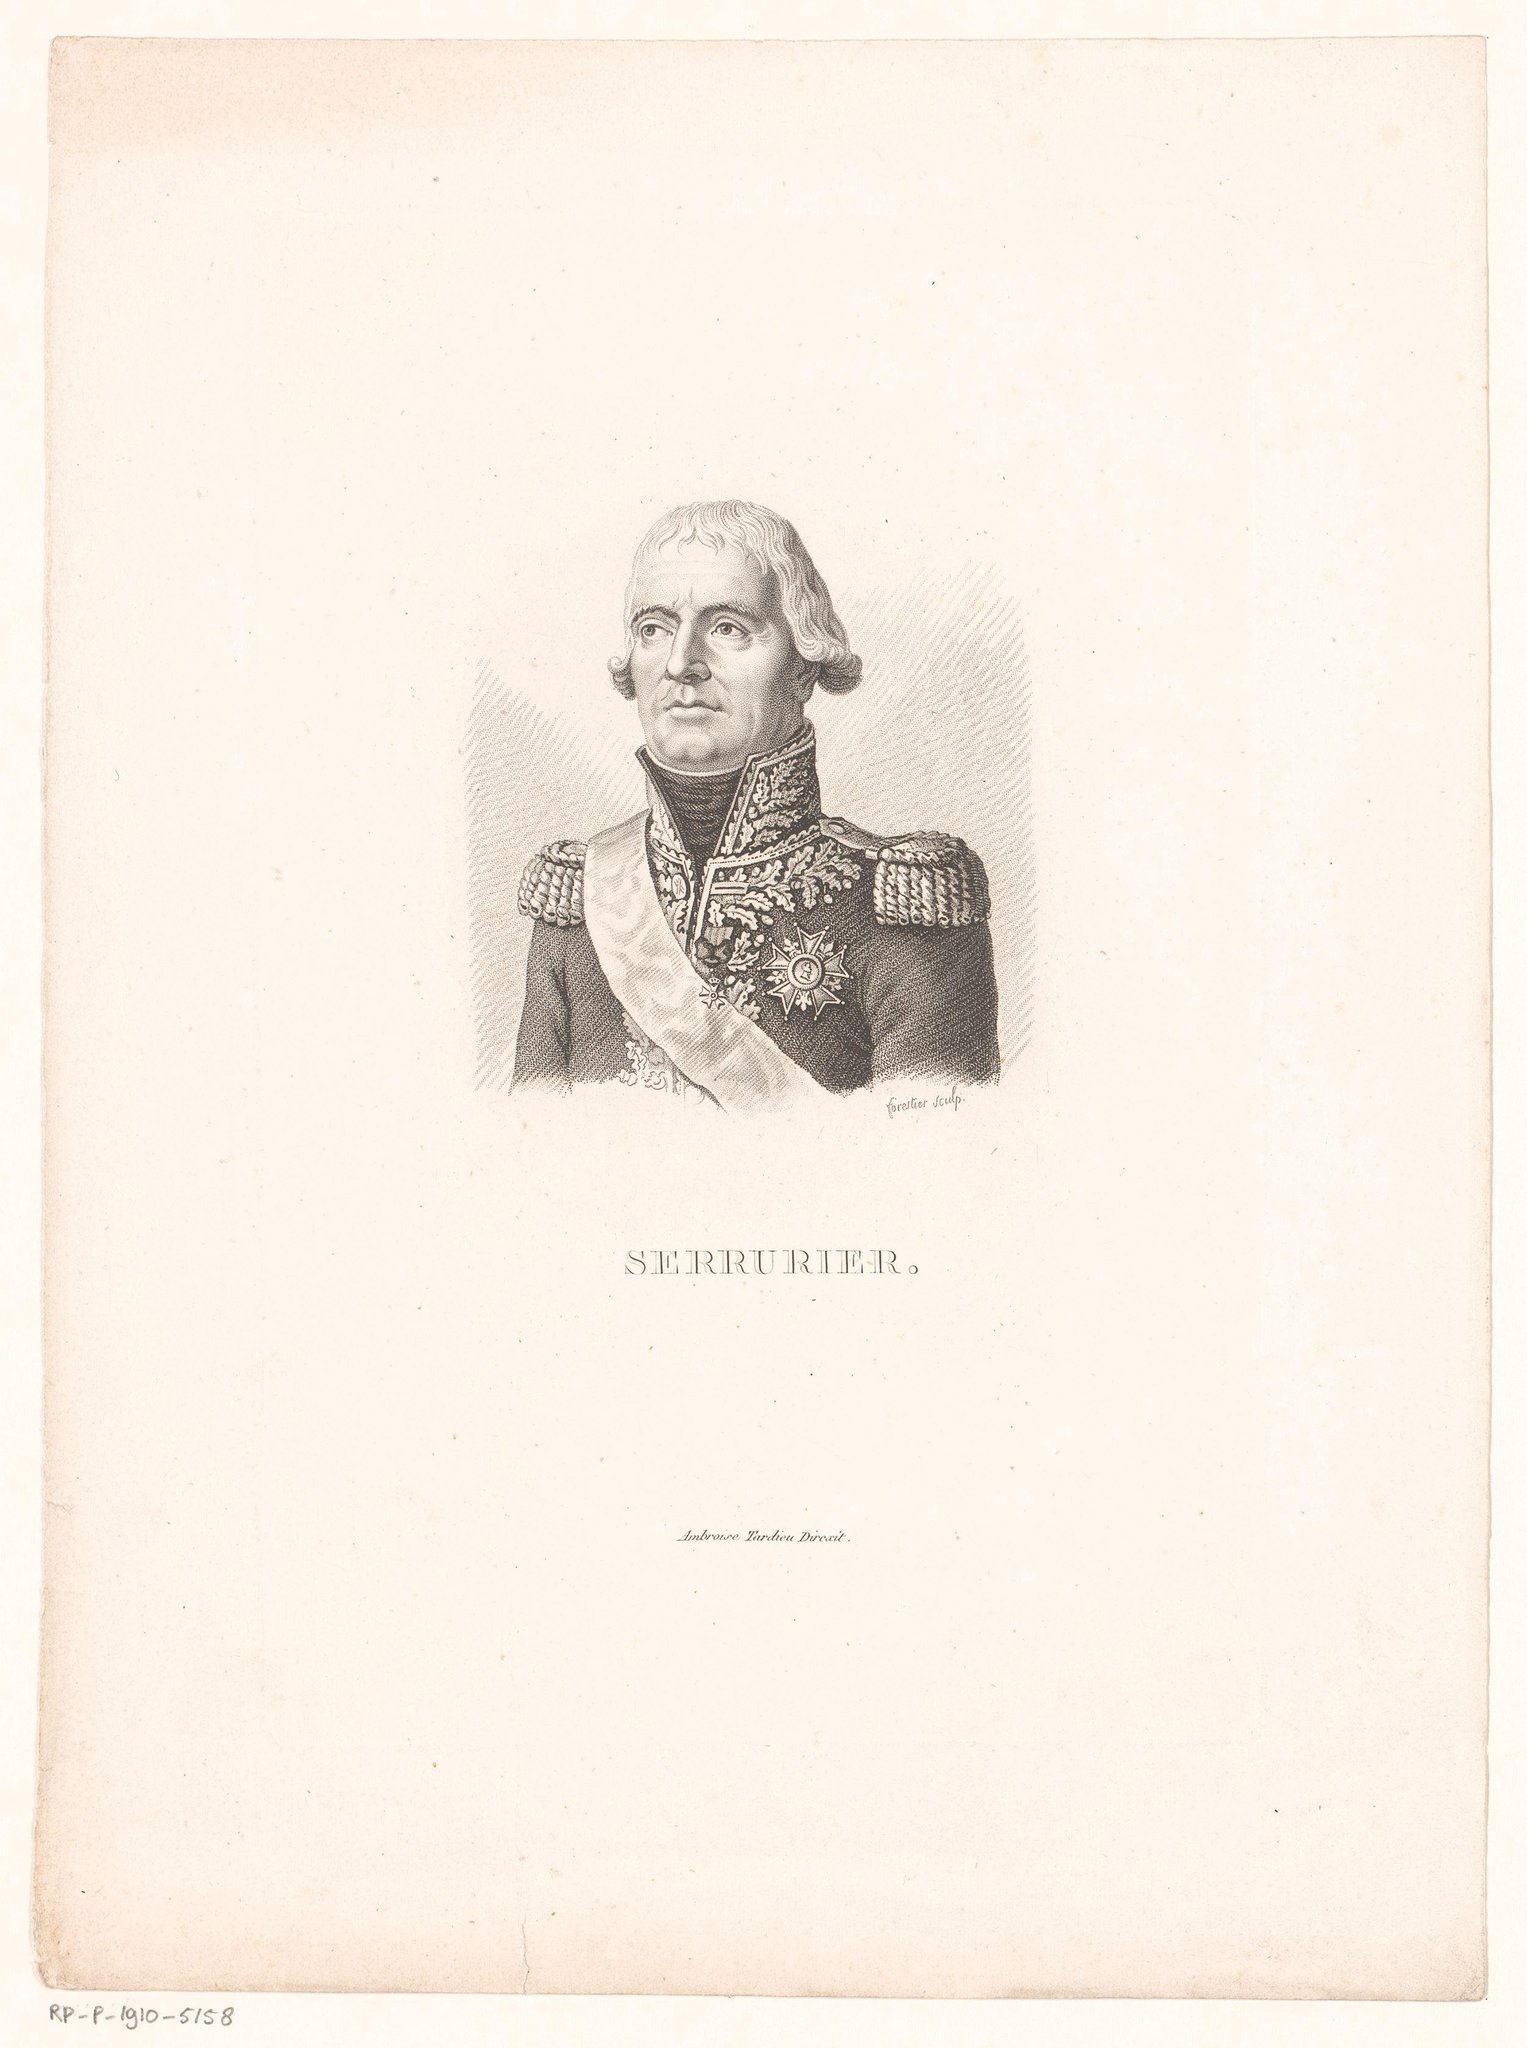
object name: print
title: Portret van Jean-Mathieu-Philibert Sérurier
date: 1818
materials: paper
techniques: etching, roulette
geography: paris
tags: paris, politician, commander-in-chief, general, marshal, historical persons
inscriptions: collector's mark: Lugt 2228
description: Mogelijk prent uit: Tardieu, Ambroise. Portraits des généraux français, faisant suite aux "Victoires et conquêtes des Français". Parijs: Panckoucke, Charles Louis Fleury, ca. 1818.